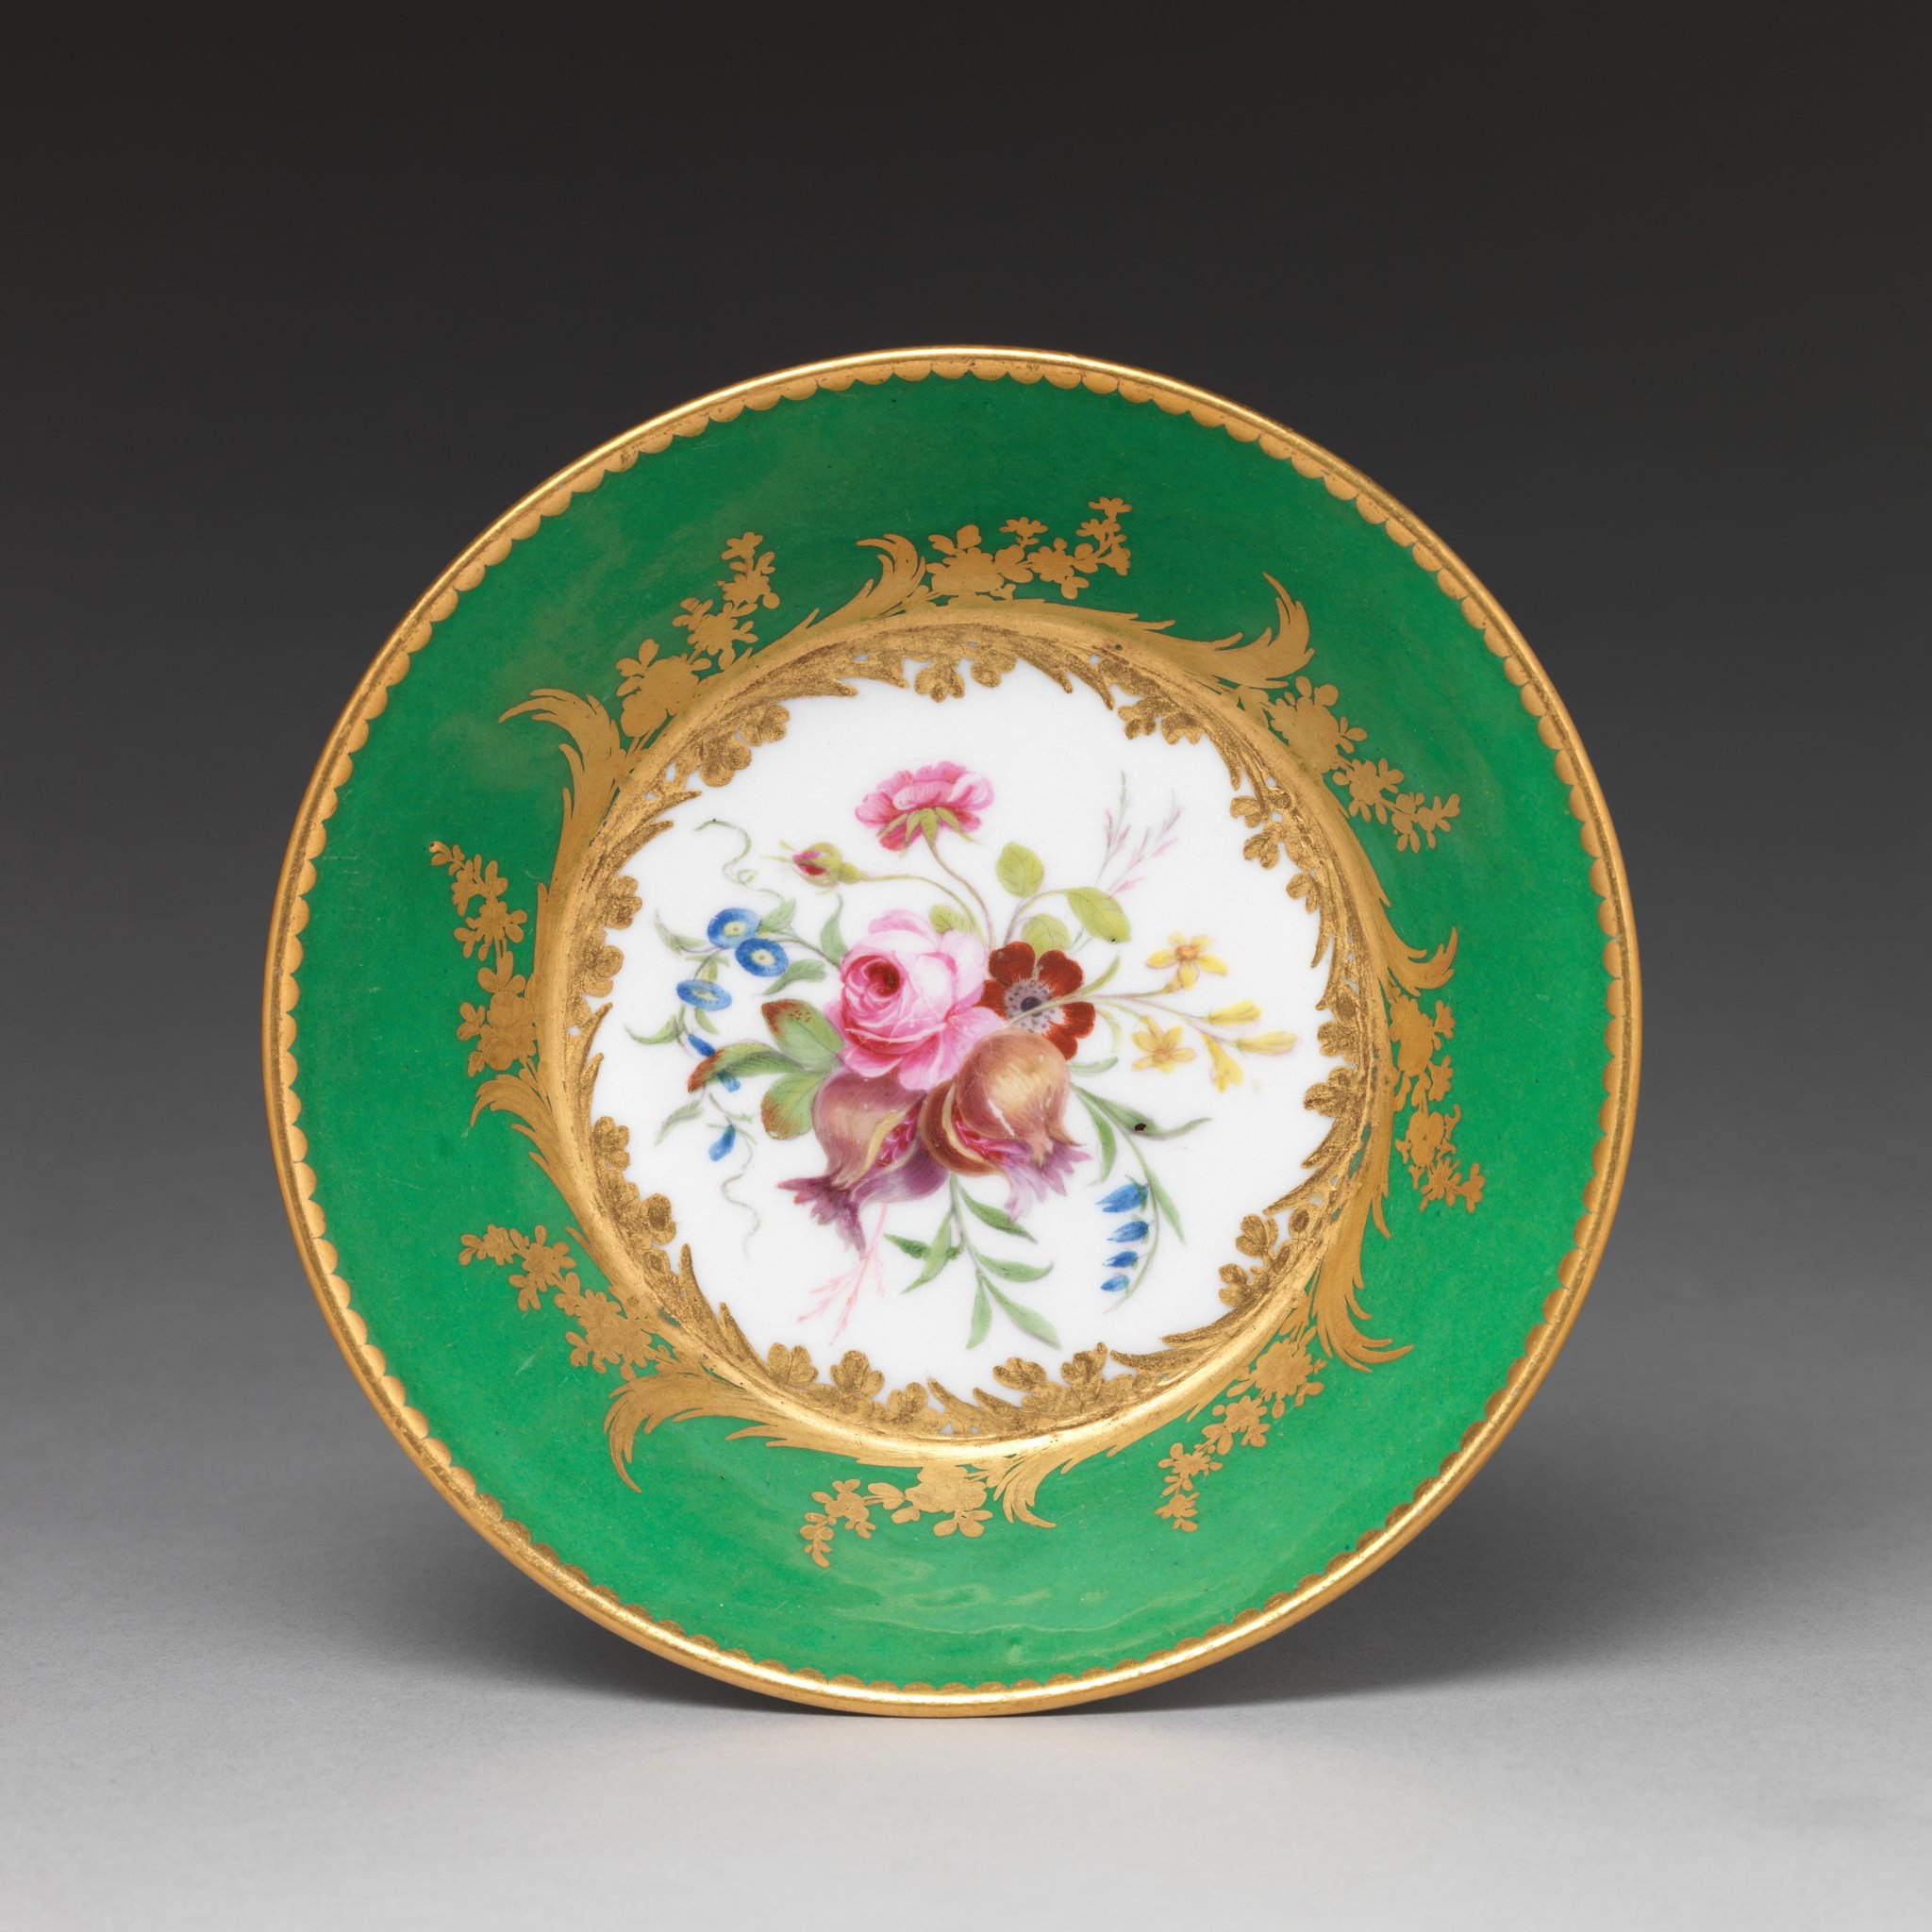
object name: saucer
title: Saucer (one of nine) (part of a service)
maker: sèvres manufactory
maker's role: manufactory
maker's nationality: french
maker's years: 1740-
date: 1787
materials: soft paste porcelain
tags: flowers